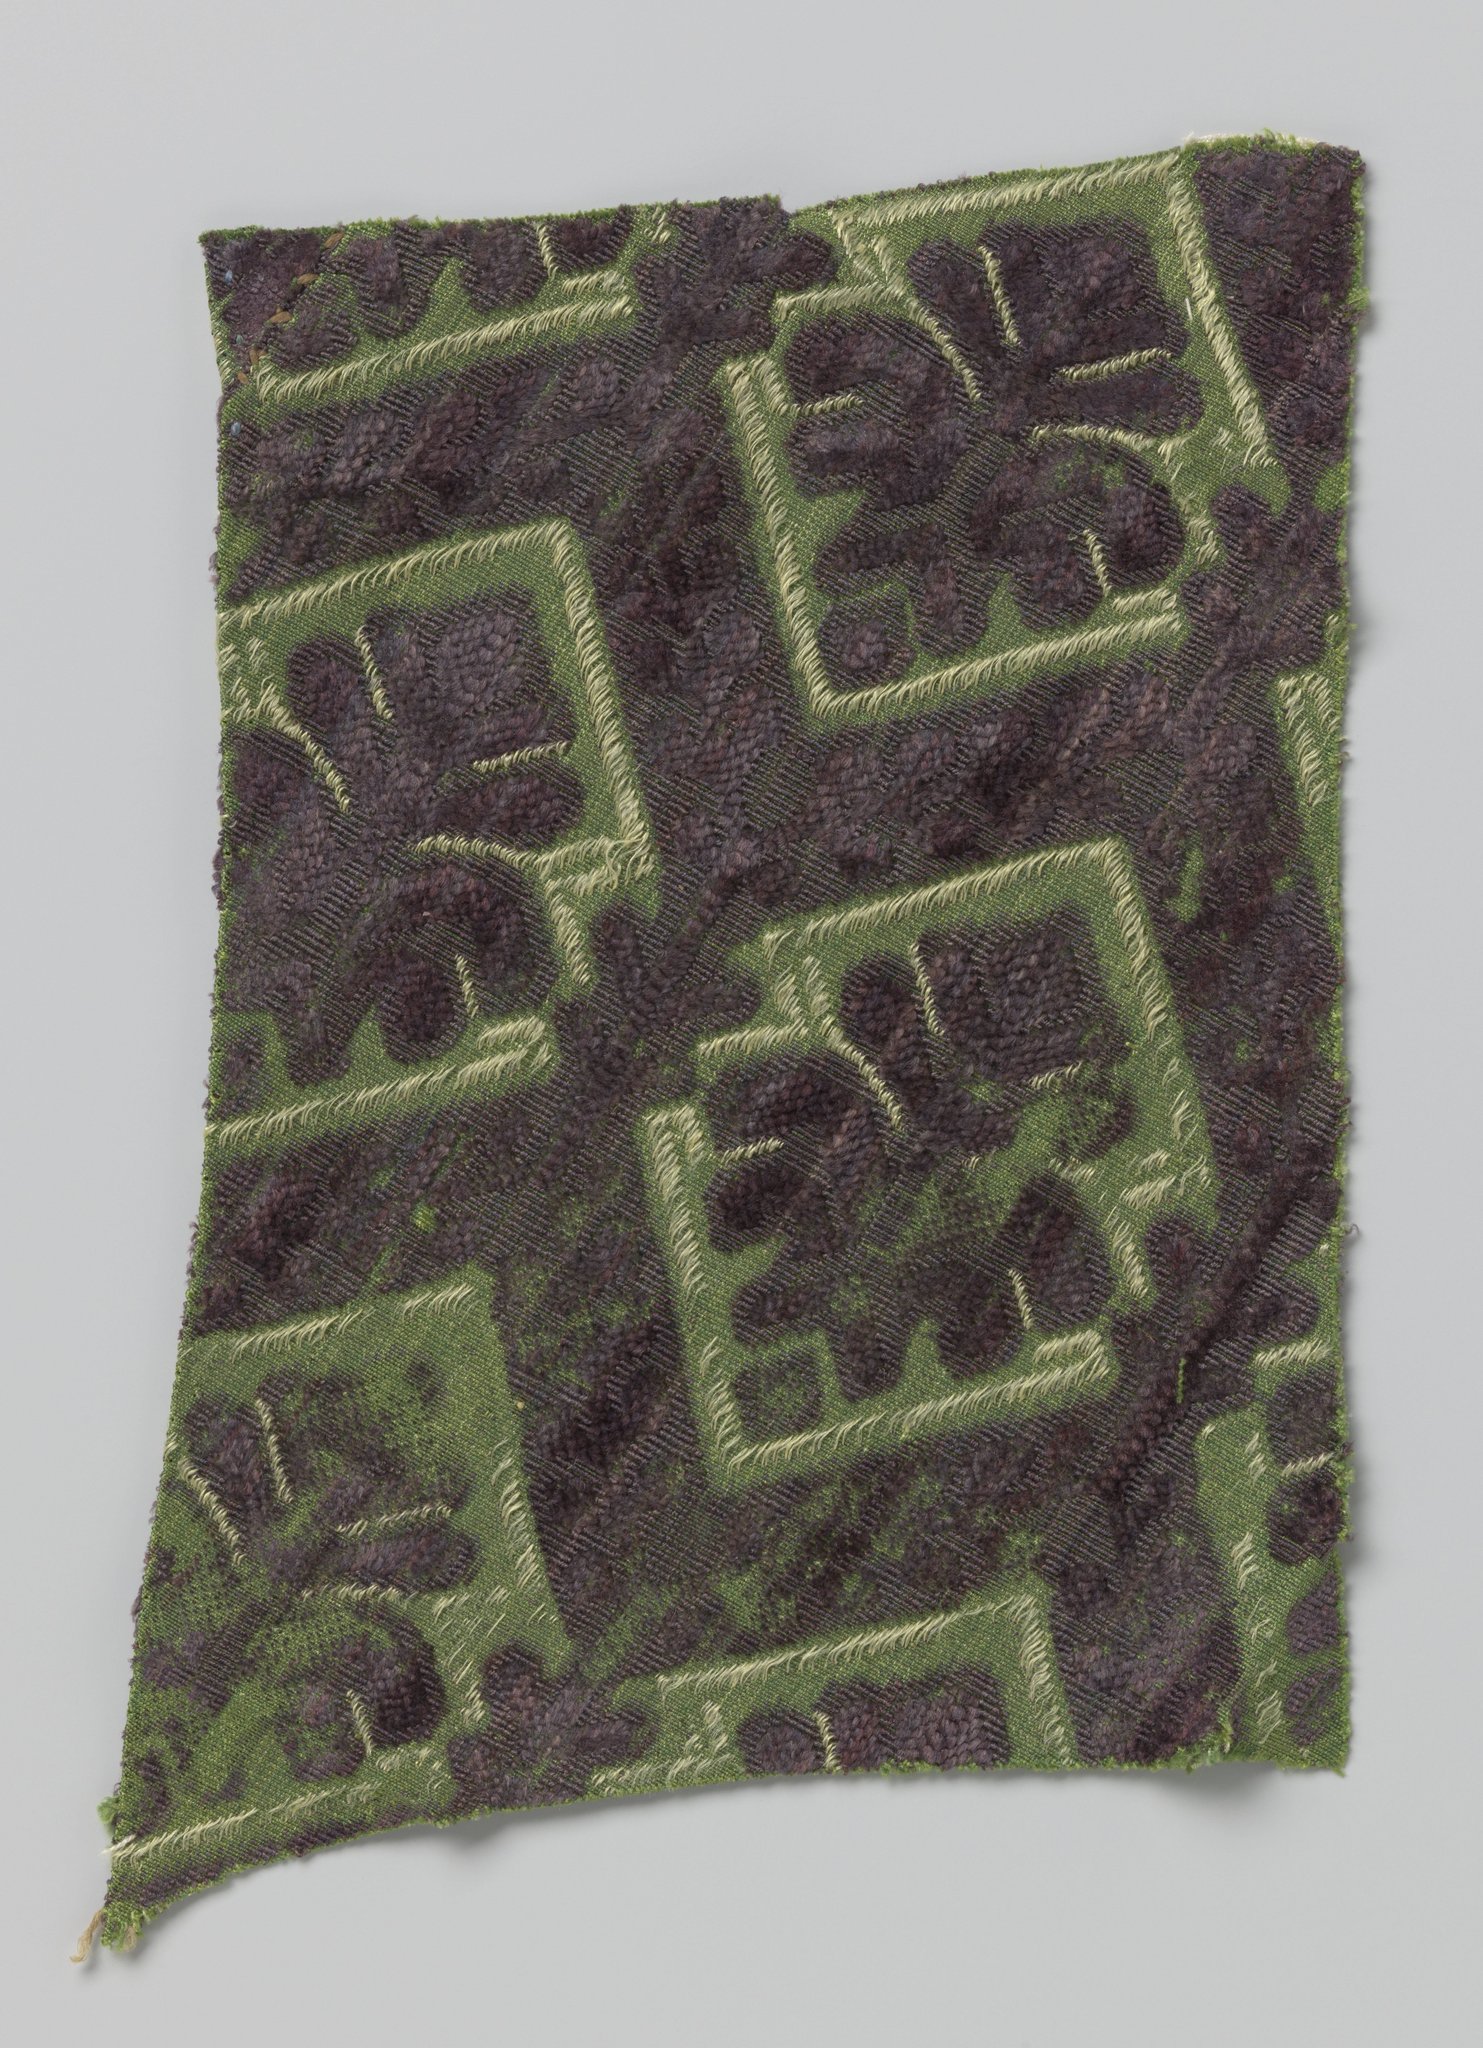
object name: zijdefluweel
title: Fragment van zijdefluweel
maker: Anonymous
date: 1550-1599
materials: ciselé velvet, silk, velvet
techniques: weave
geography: italy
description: Een fragment van zijden polychroom fluweel, gedecoreerd met ruiten, waarin palmetvormige bladen in paars fluweel op groenen fond.